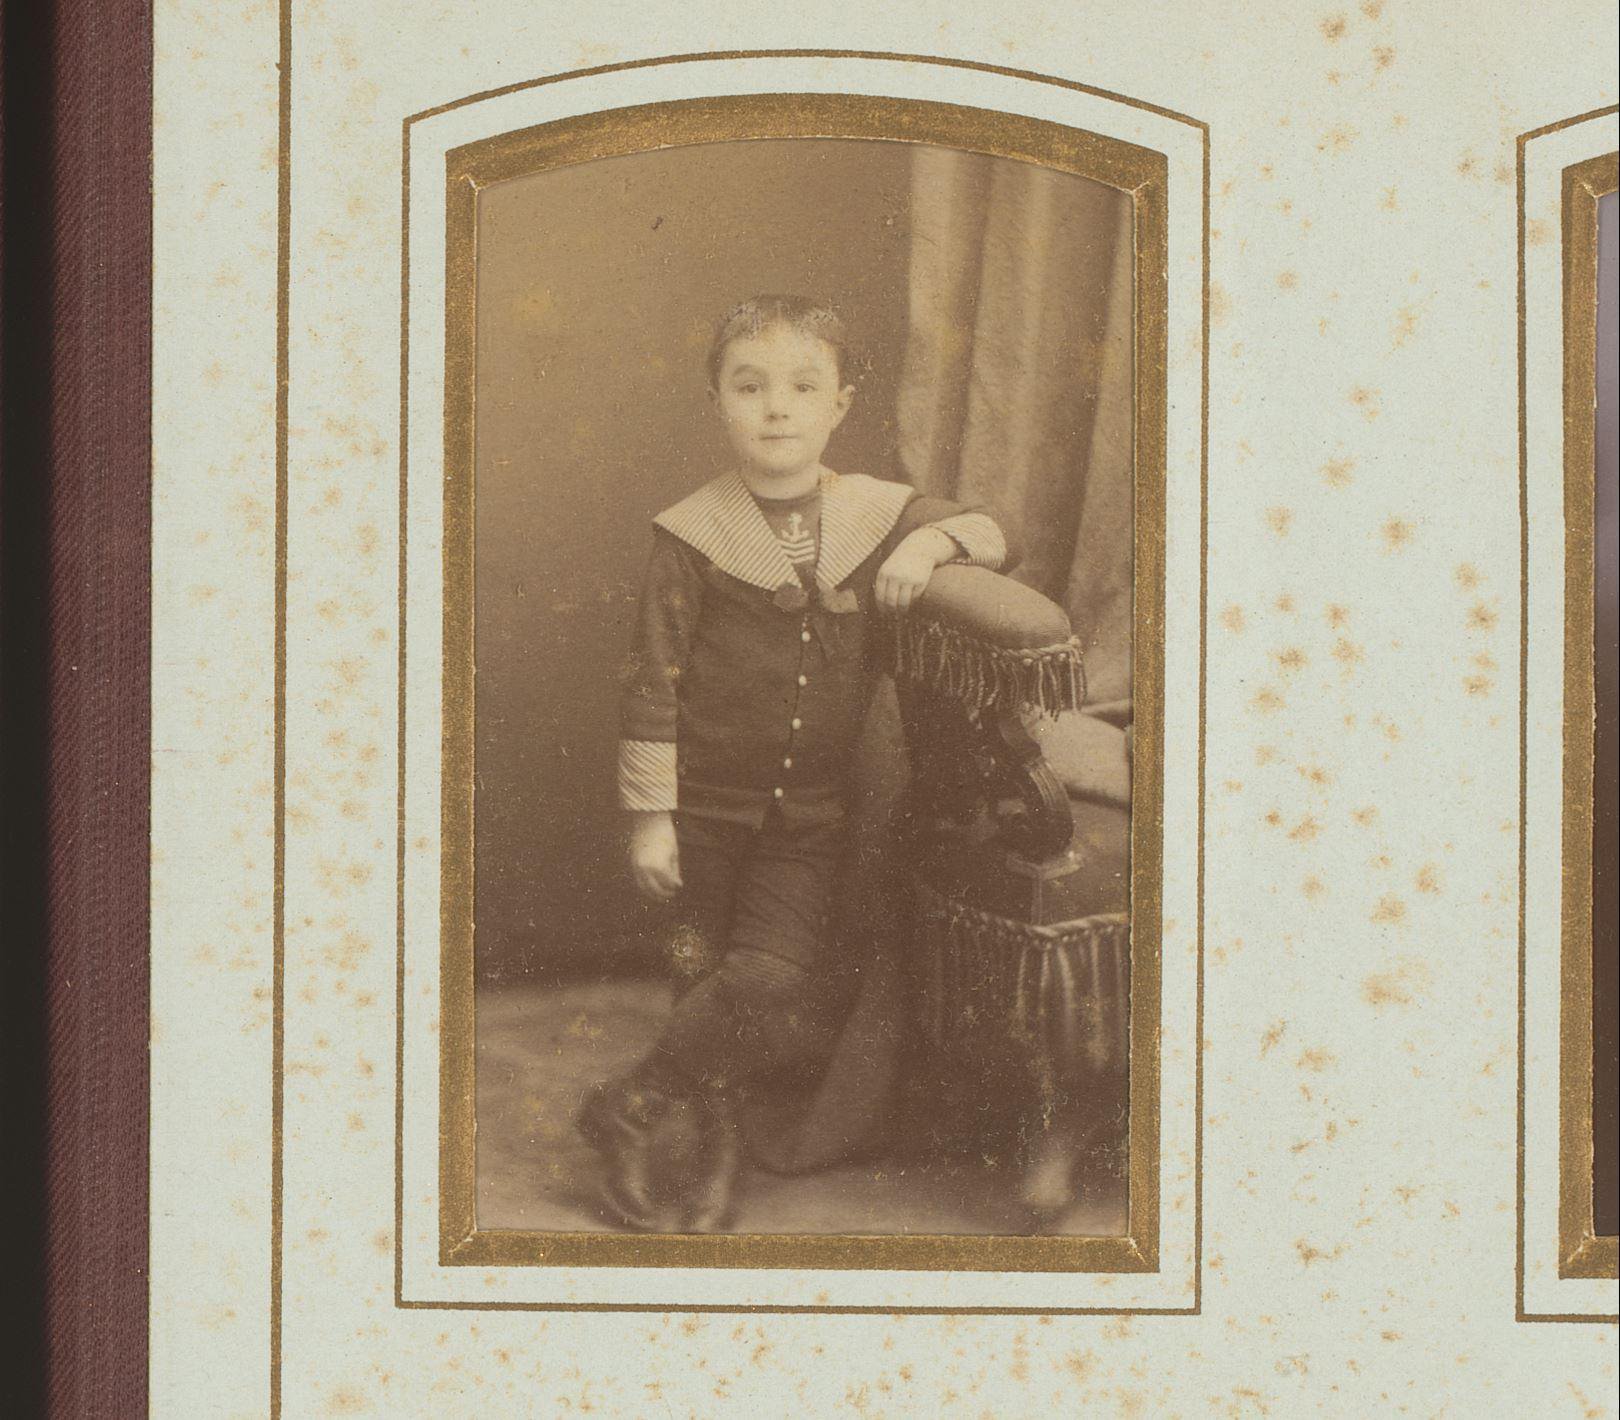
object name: carte de visite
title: Portret van een jongen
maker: Anonymous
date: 1860-1900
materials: cardboard, photographic support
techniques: albumen print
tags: boy (child between toddler and youth)